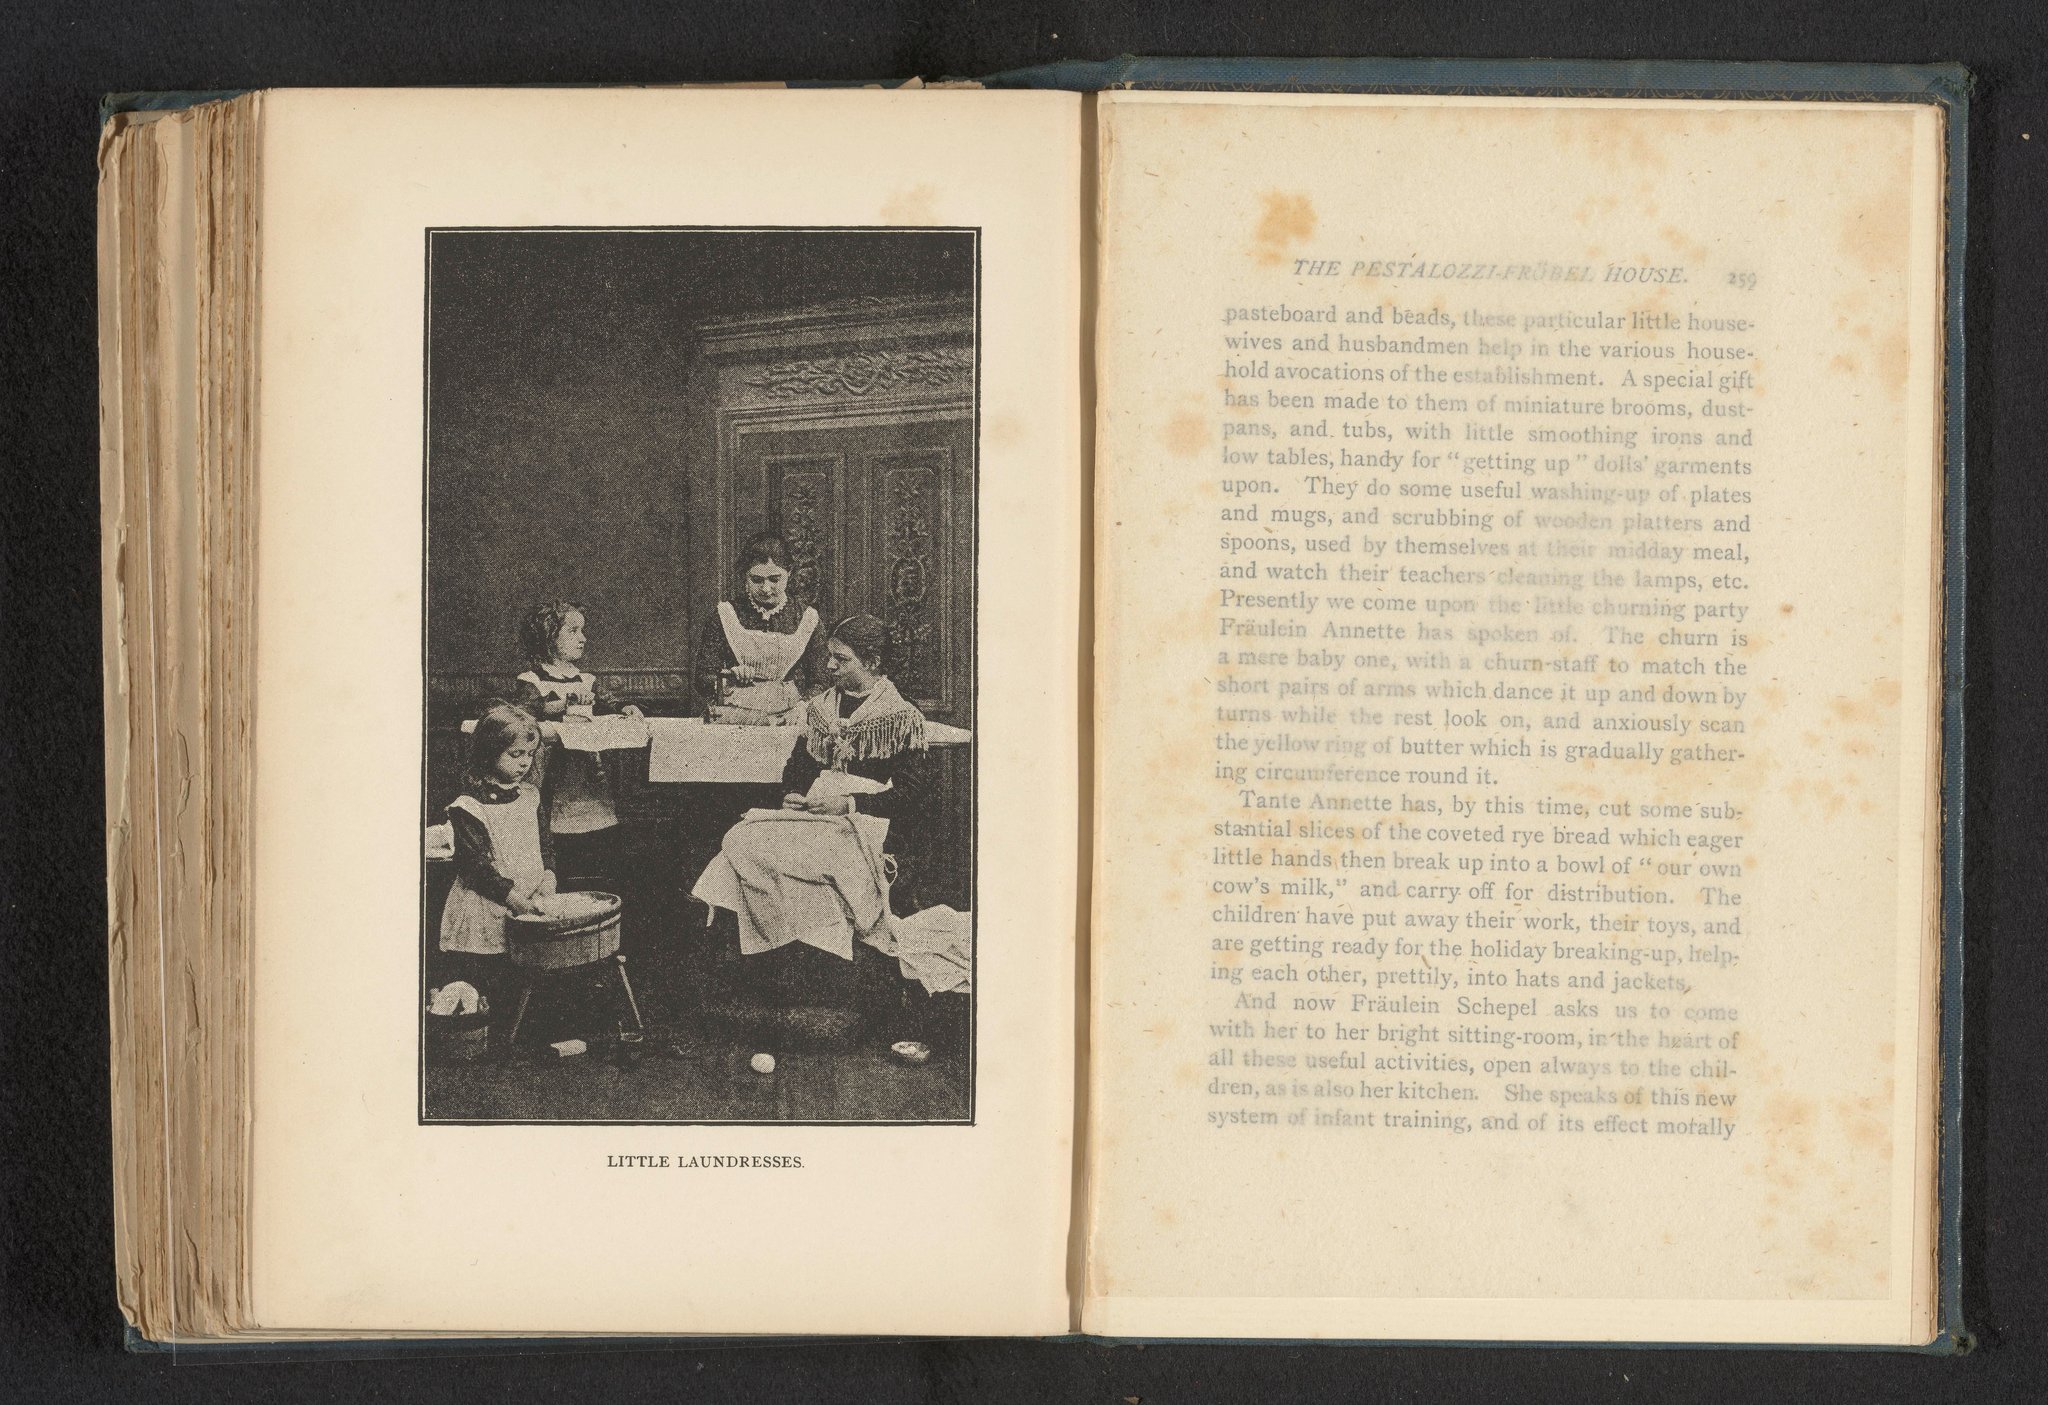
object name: page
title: Little laundresses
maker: Anonymous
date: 1883-1888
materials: paper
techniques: autotype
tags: ironing, interior ~ representation of a building, wash house, home laundry, laundry room